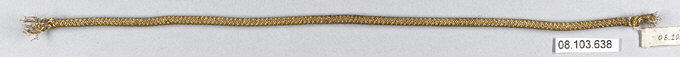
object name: cord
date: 1701-1900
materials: metal thread